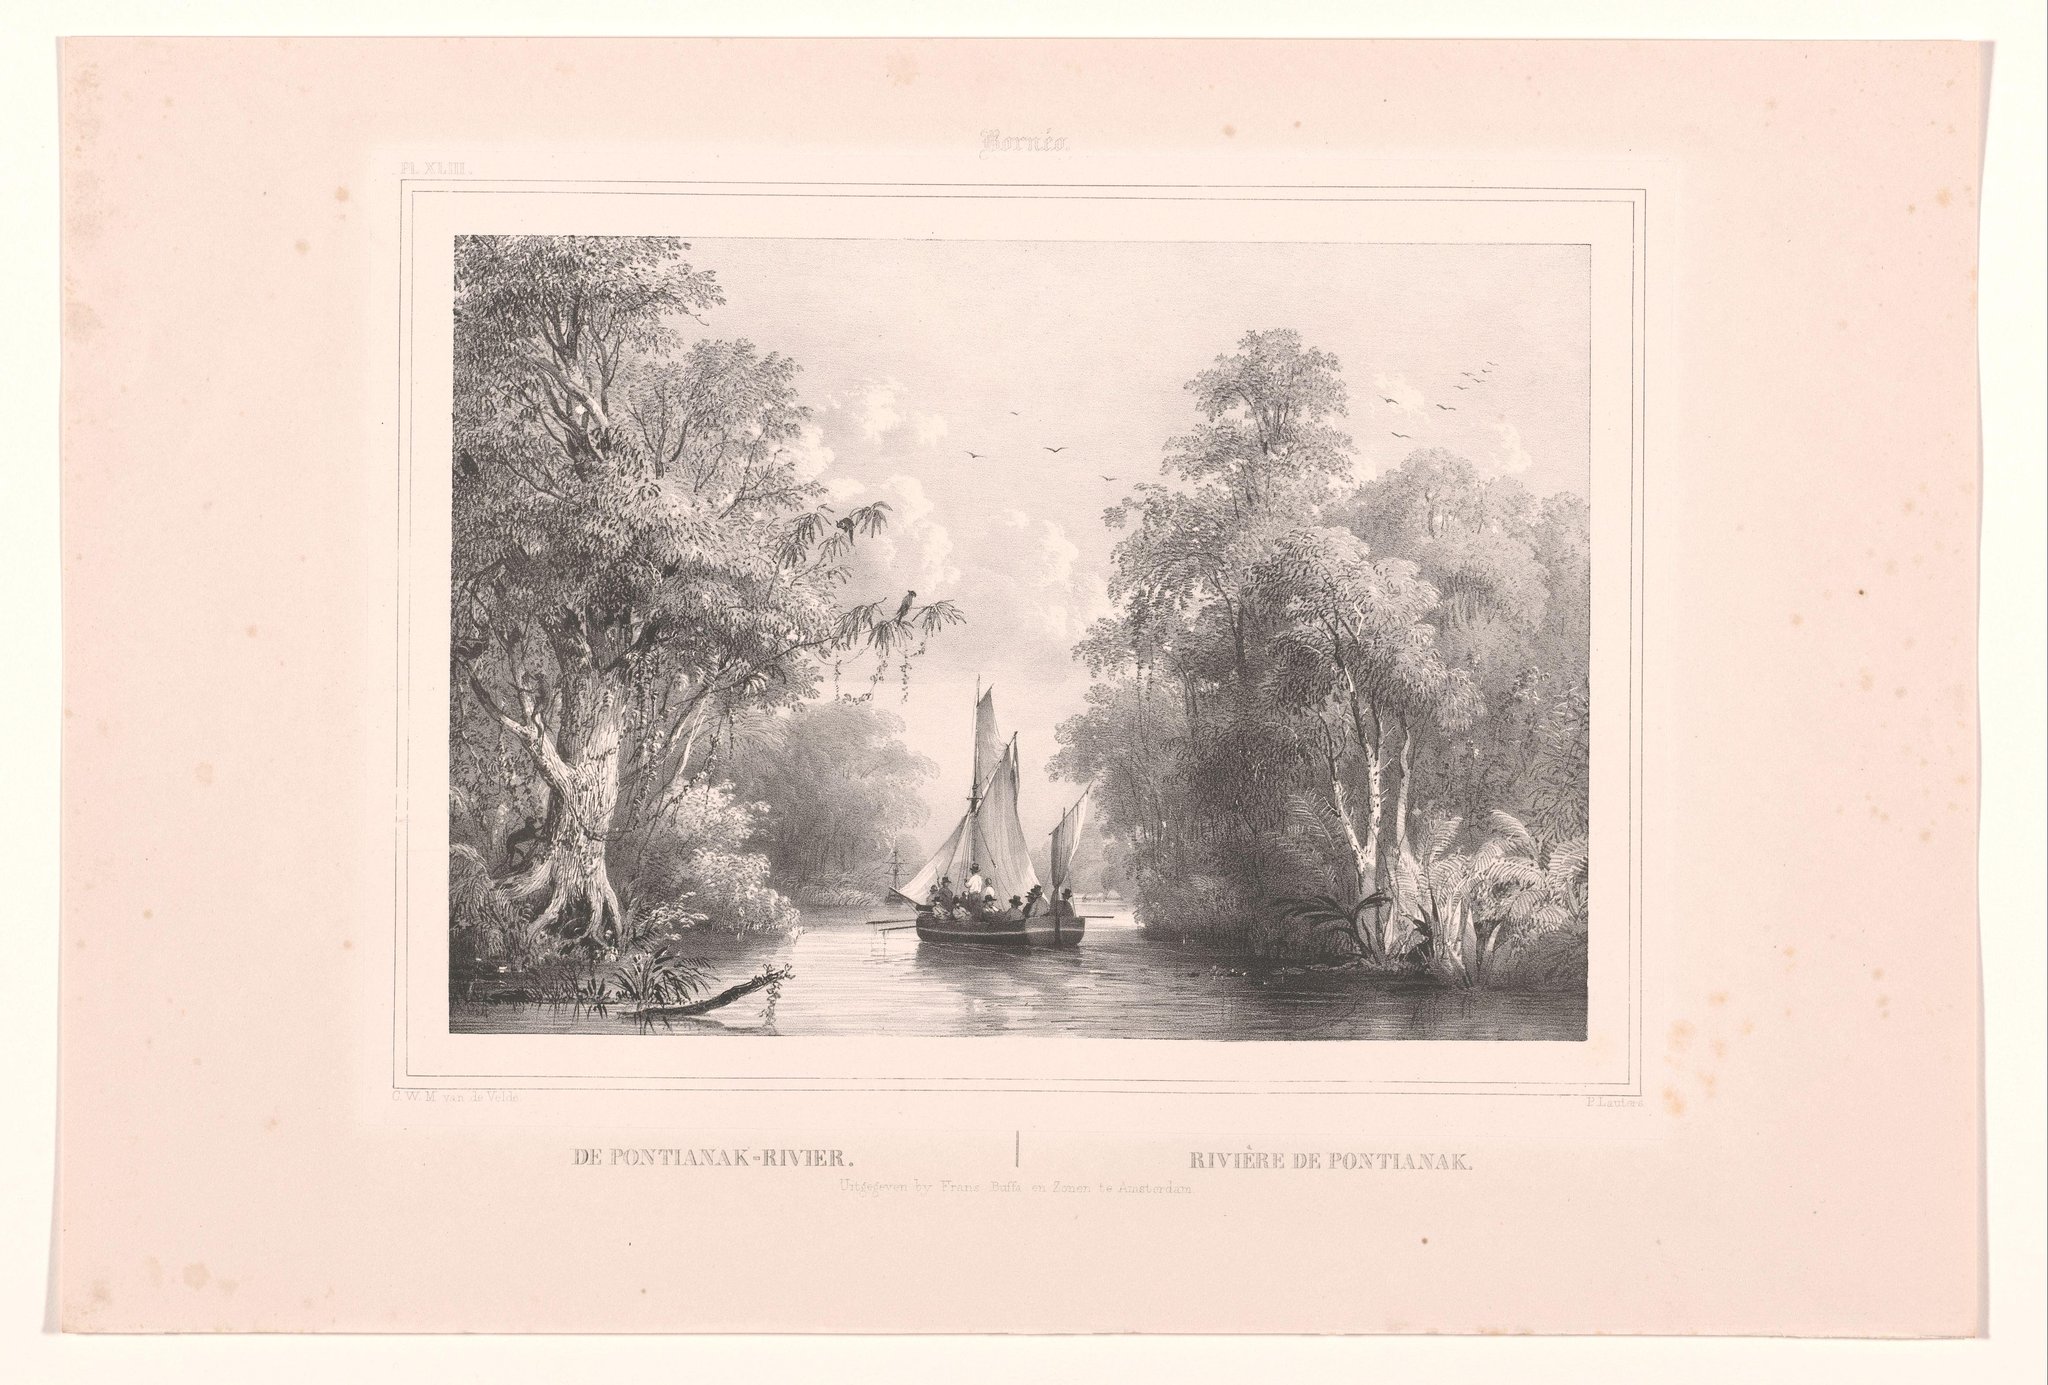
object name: print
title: De Pontianak-rivier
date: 1843-1845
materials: paper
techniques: lithograph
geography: amsterdam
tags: sailing-ship, sailing-boat, river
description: Op het water vaart een zeilboot vol met mannen. Genummerd linksboven: Pl. XLIII. De prent maakt deel uit van een omslag met zes bladen.